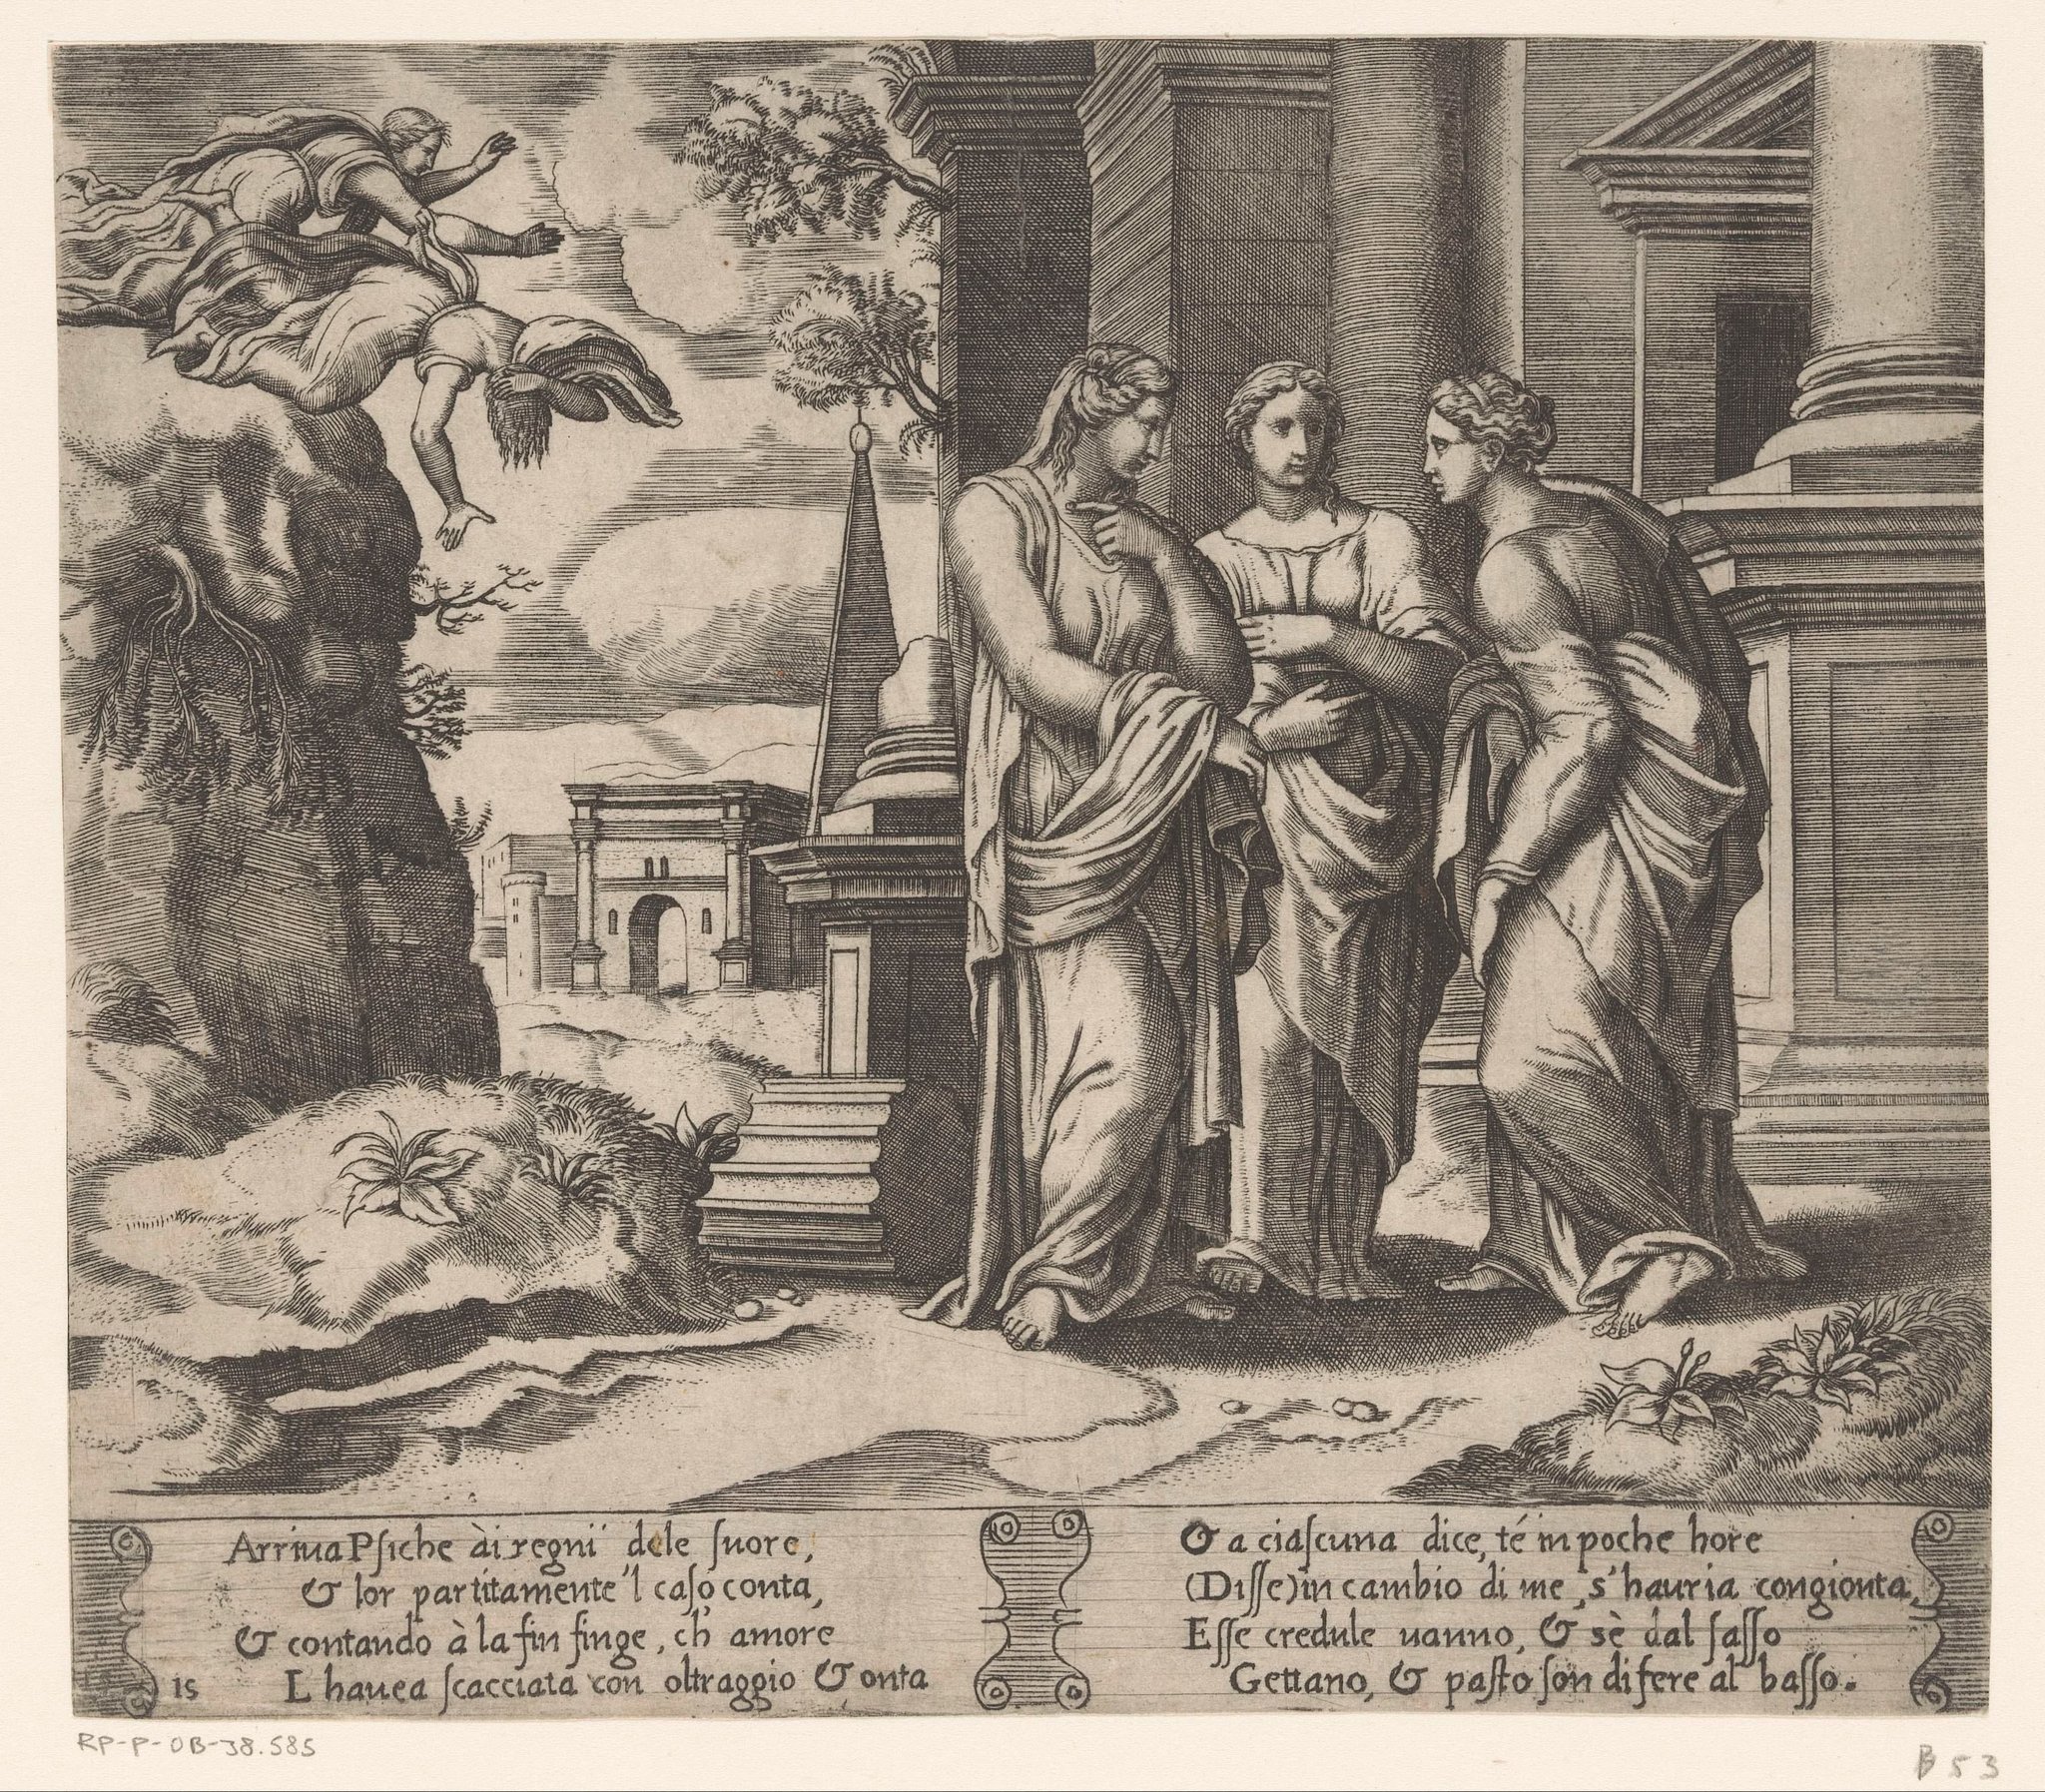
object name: print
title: Verhaal van Amor en Psyche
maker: meester van de dobbelsteen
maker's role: print maker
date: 1530-1560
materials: paper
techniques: engraving, intaglio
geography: italy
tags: vengeance of psyche on her sisters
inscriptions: collector's mark: Lugt 2228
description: Psyche vertelt aan haar twee zusters dat Amor haar heeft verlaten. Links de twee zusters die zich van een berg storten in de hoop naar Amor te worden gebracht door Zephyrus (de personificatie van de westenwind). Italiaanse tekst in twee cartouches in ondermarge. Tweemaal genummerd linksonder: 15.